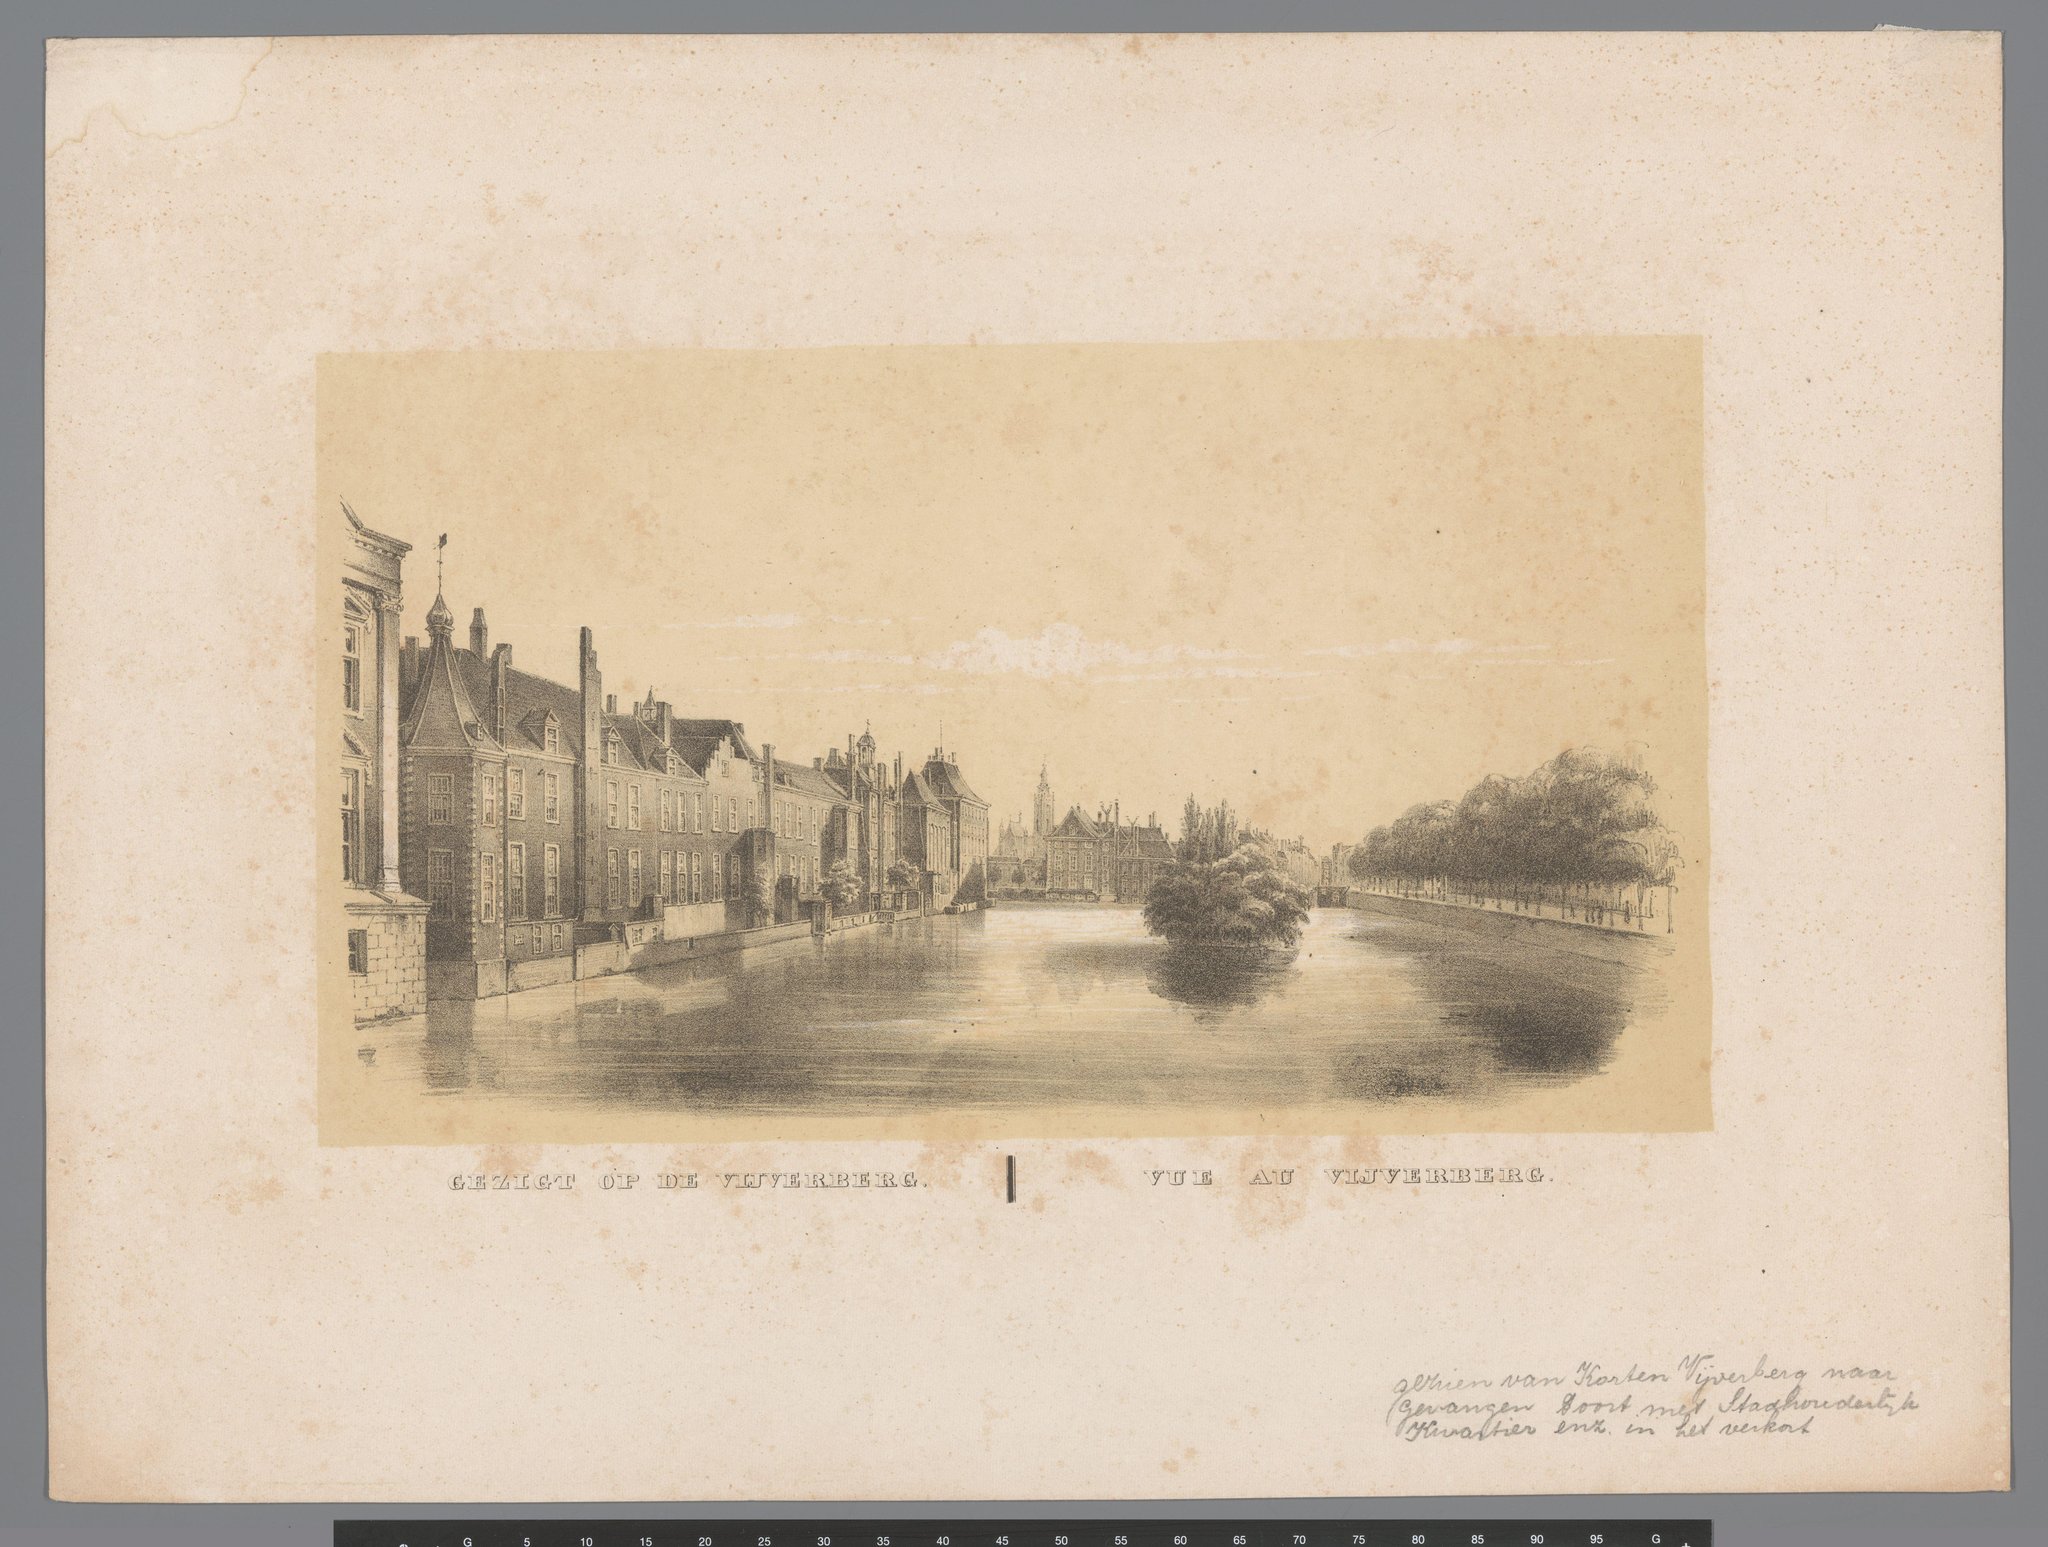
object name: print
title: Gezicht op de Vijverberg / Vue au Vijverberg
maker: Anonymous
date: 1830-1850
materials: paper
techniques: tone lithography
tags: canals, waters (in city), the hague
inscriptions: collector's mark: Lugt 2228